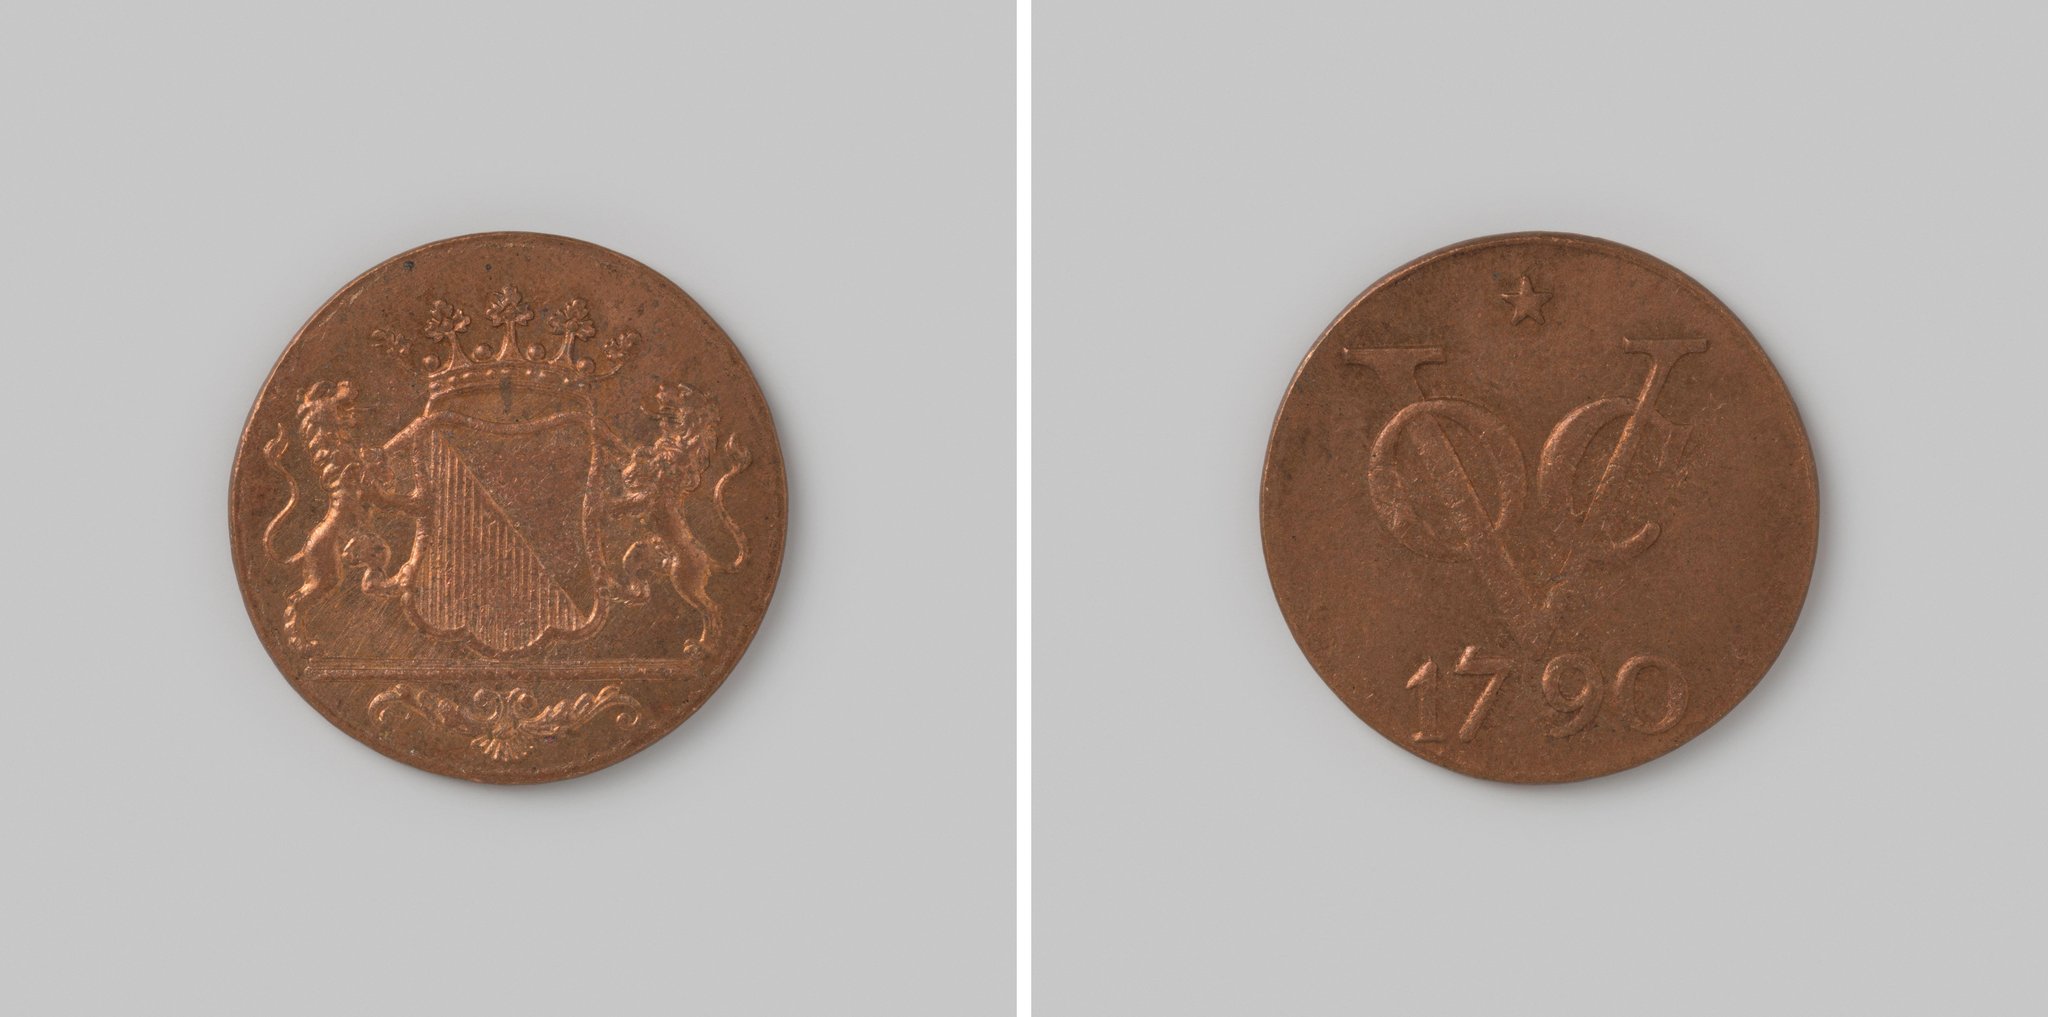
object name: coin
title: Dubbele duit op naam van de VOC en de stad Utrecht met jaartal1790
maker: william ii of the netherlands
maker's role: koning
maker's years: 1792-1849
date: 1840-1843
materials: copper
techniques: striking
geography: surabaya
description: Koperen munt. Voorzijde: op balk, waaronder guirlande, staand, door twee leeuwen gehouden gekroond wapenschild van de stad Utrecht. Keerzijde: monogram van de VOC, waarboven muntteken ster en waaronder fictief jaartal 1790. Gladde rand.